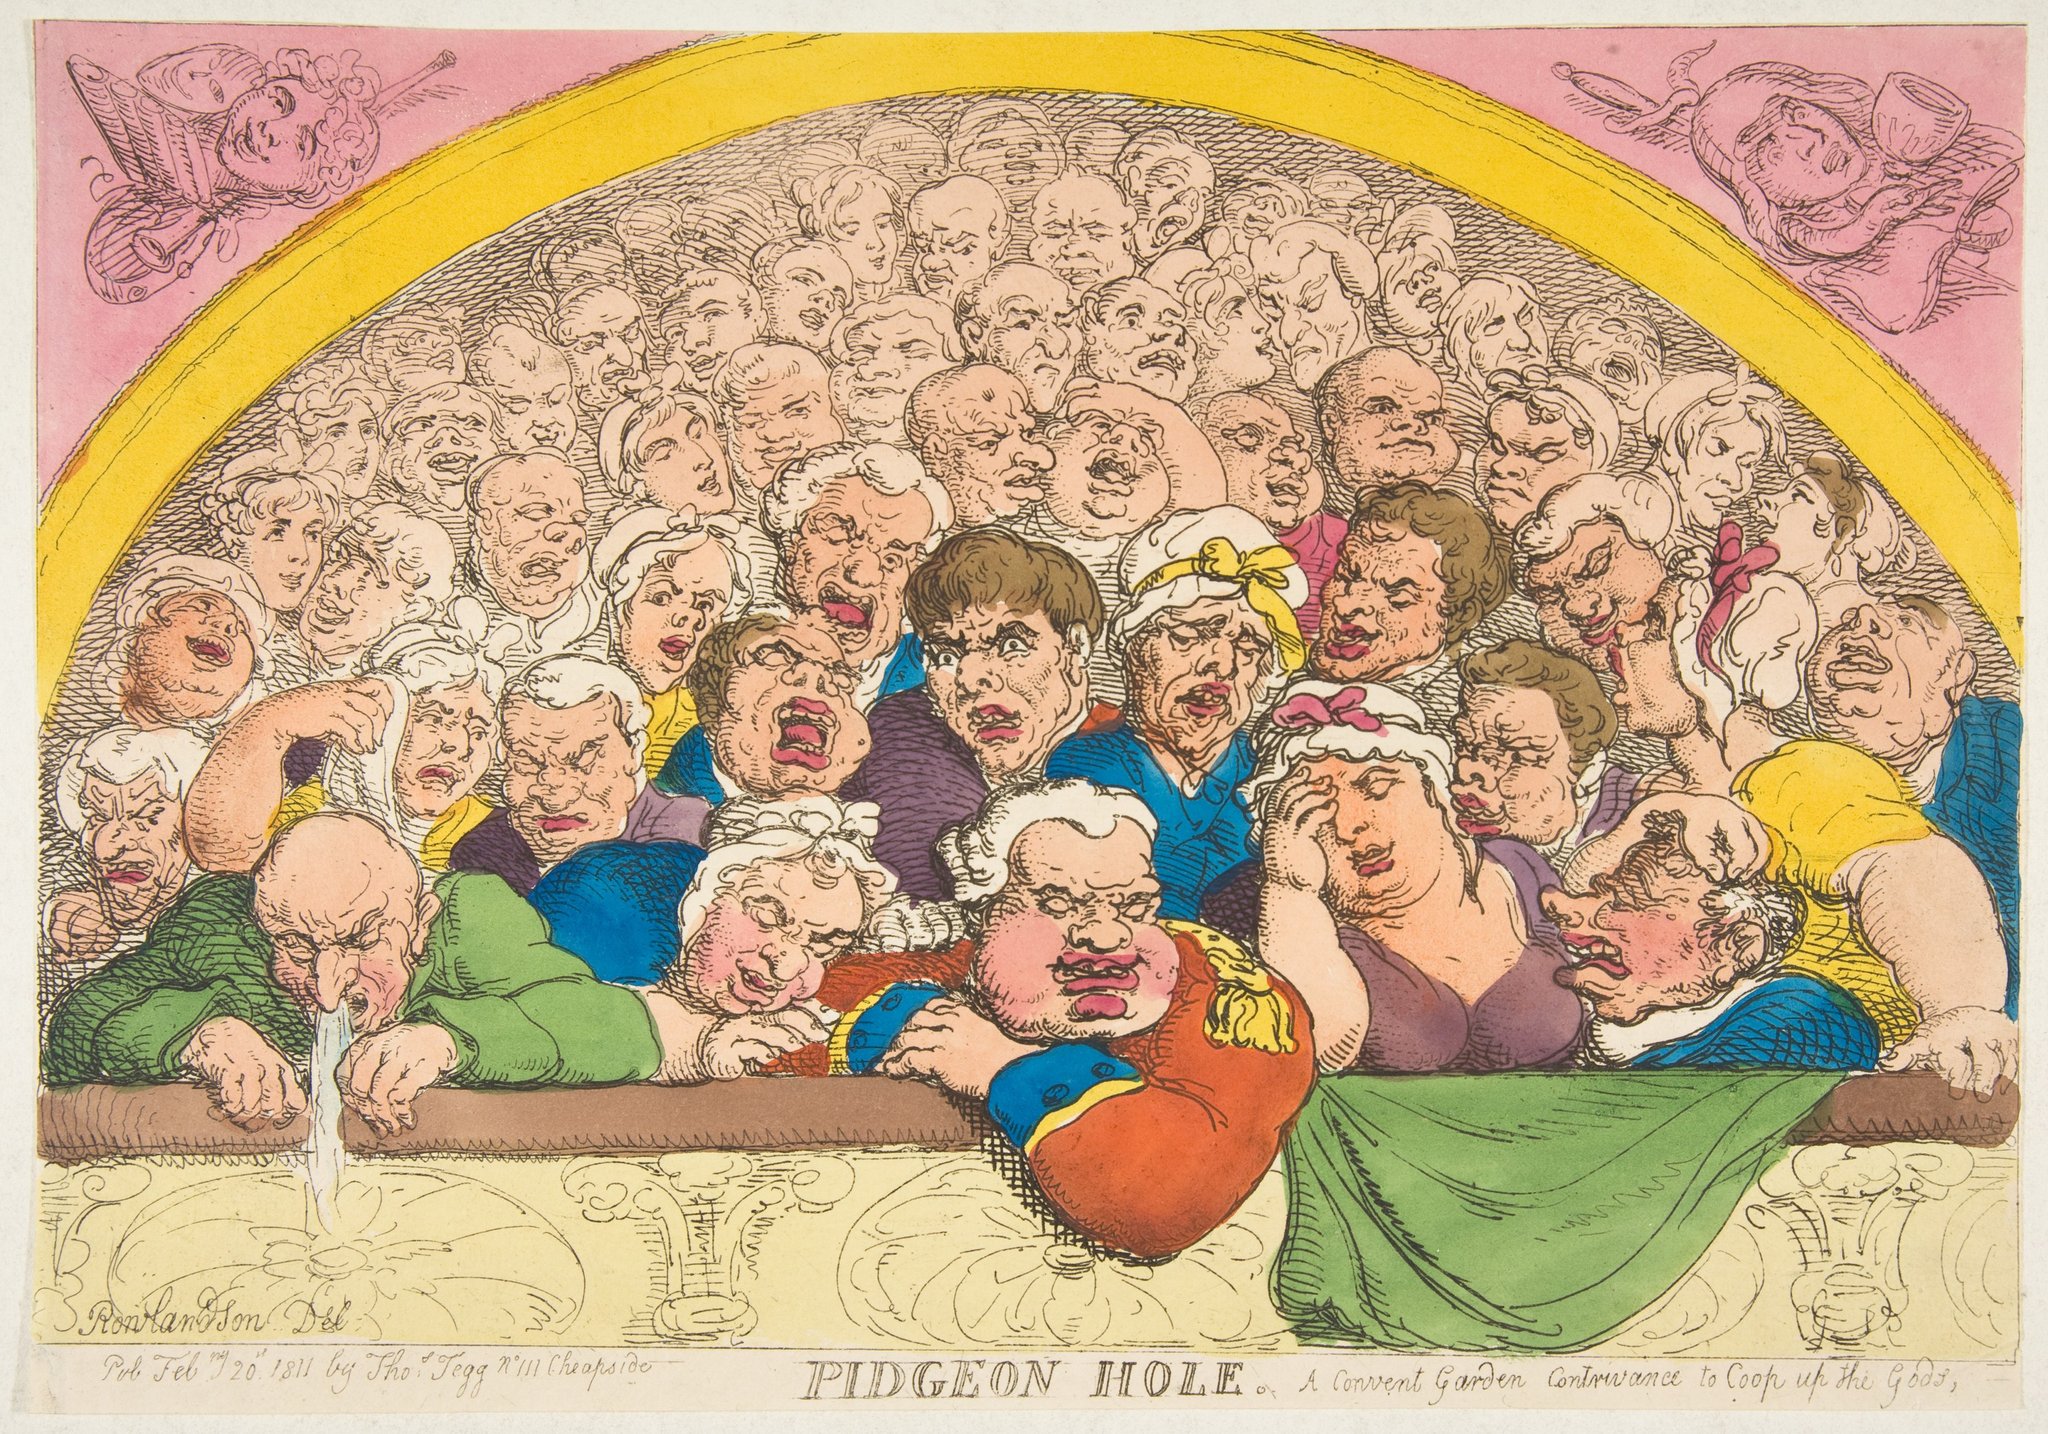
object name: print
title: Pidgeon Hole. A Convent Garden Contrivance to Coop up the Gods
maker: thomas rowlandson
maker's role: artist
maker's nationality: british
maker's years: 1757-1827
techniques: etching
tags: satire,theatre,men,women,spectators,caricature